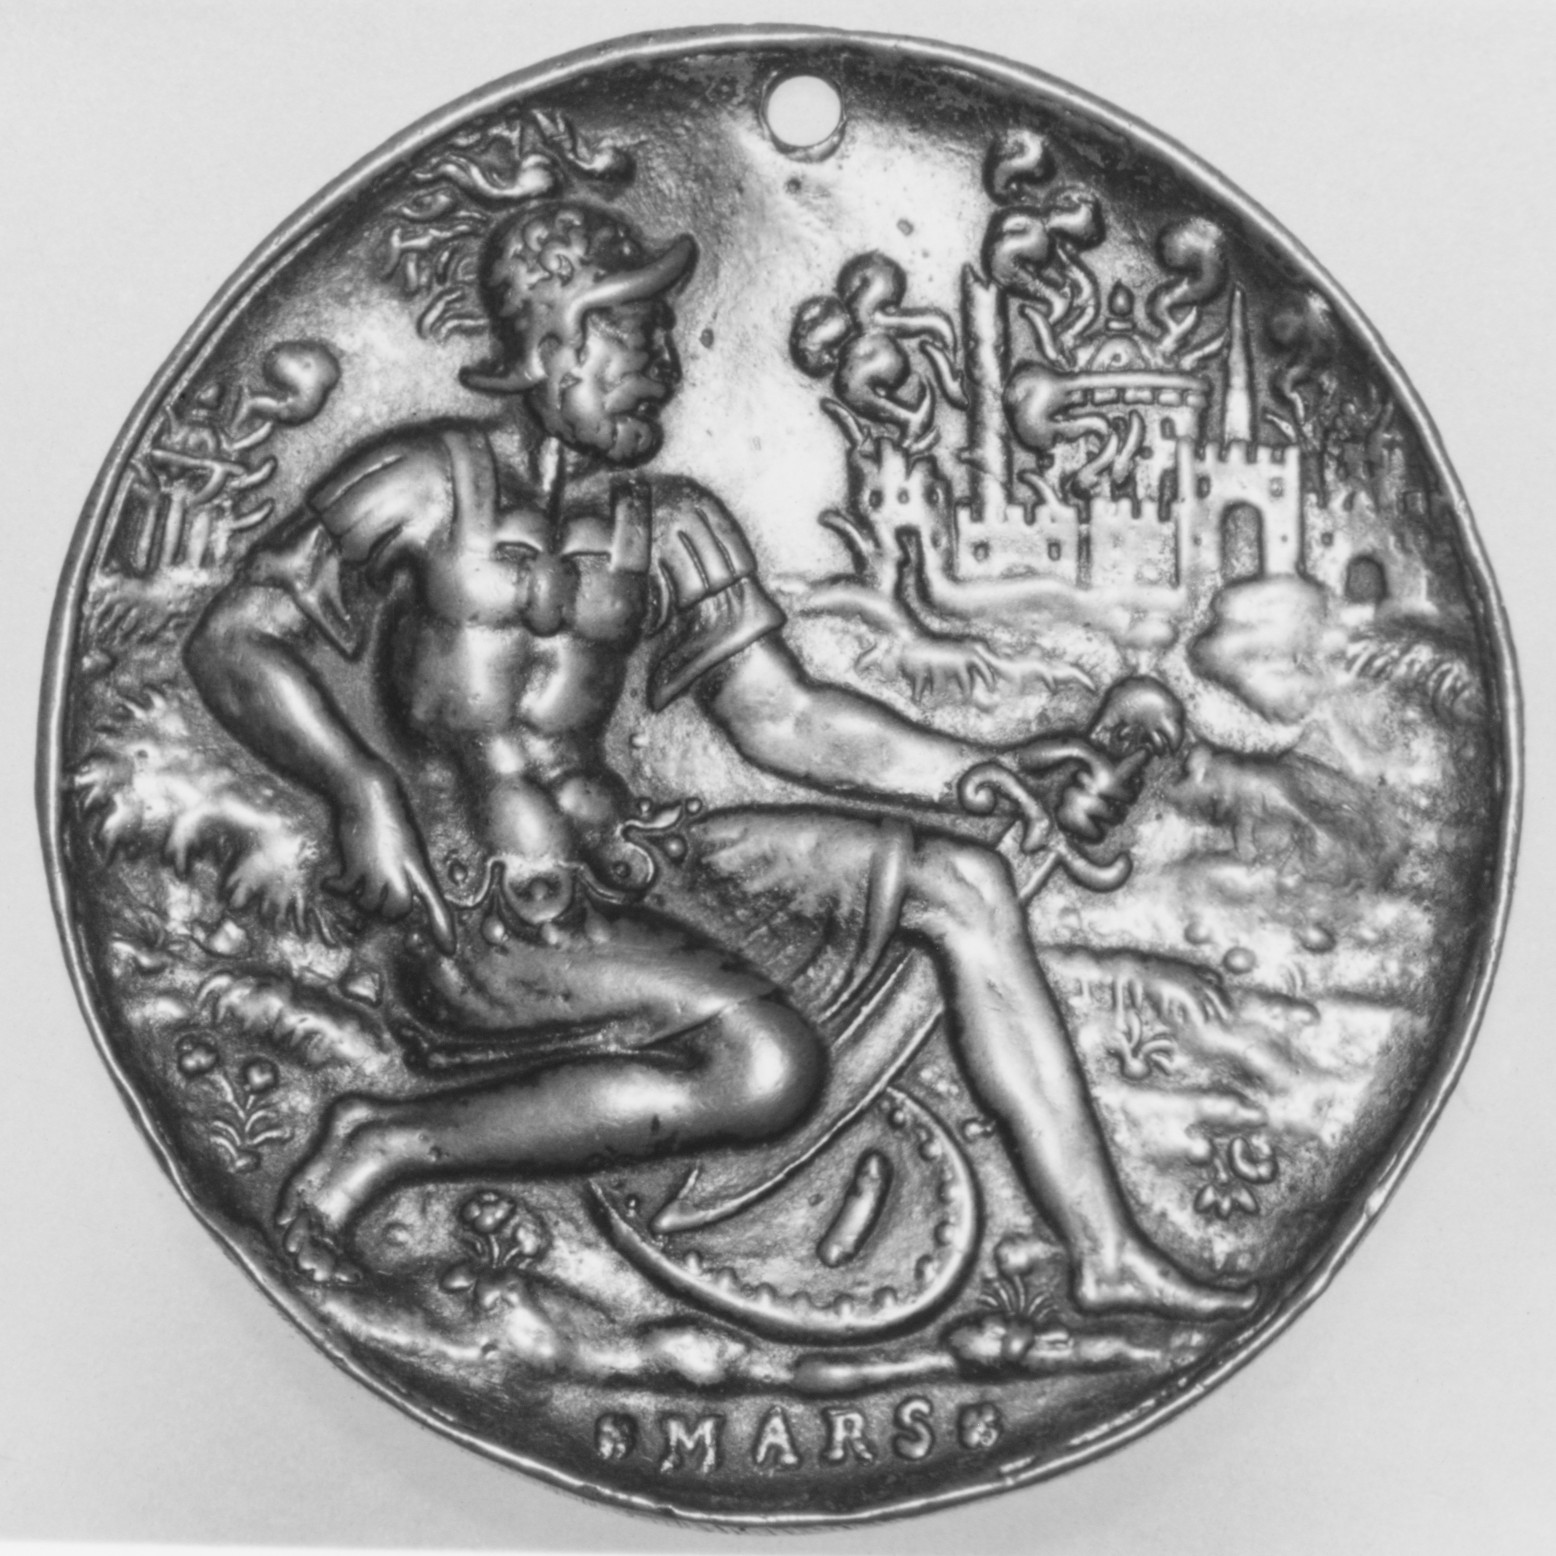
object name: plaquette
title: Mars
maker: françois briot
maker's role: artist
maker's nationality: french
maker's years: 1550-1612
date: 1610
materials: bronze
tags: shields,swords,mars